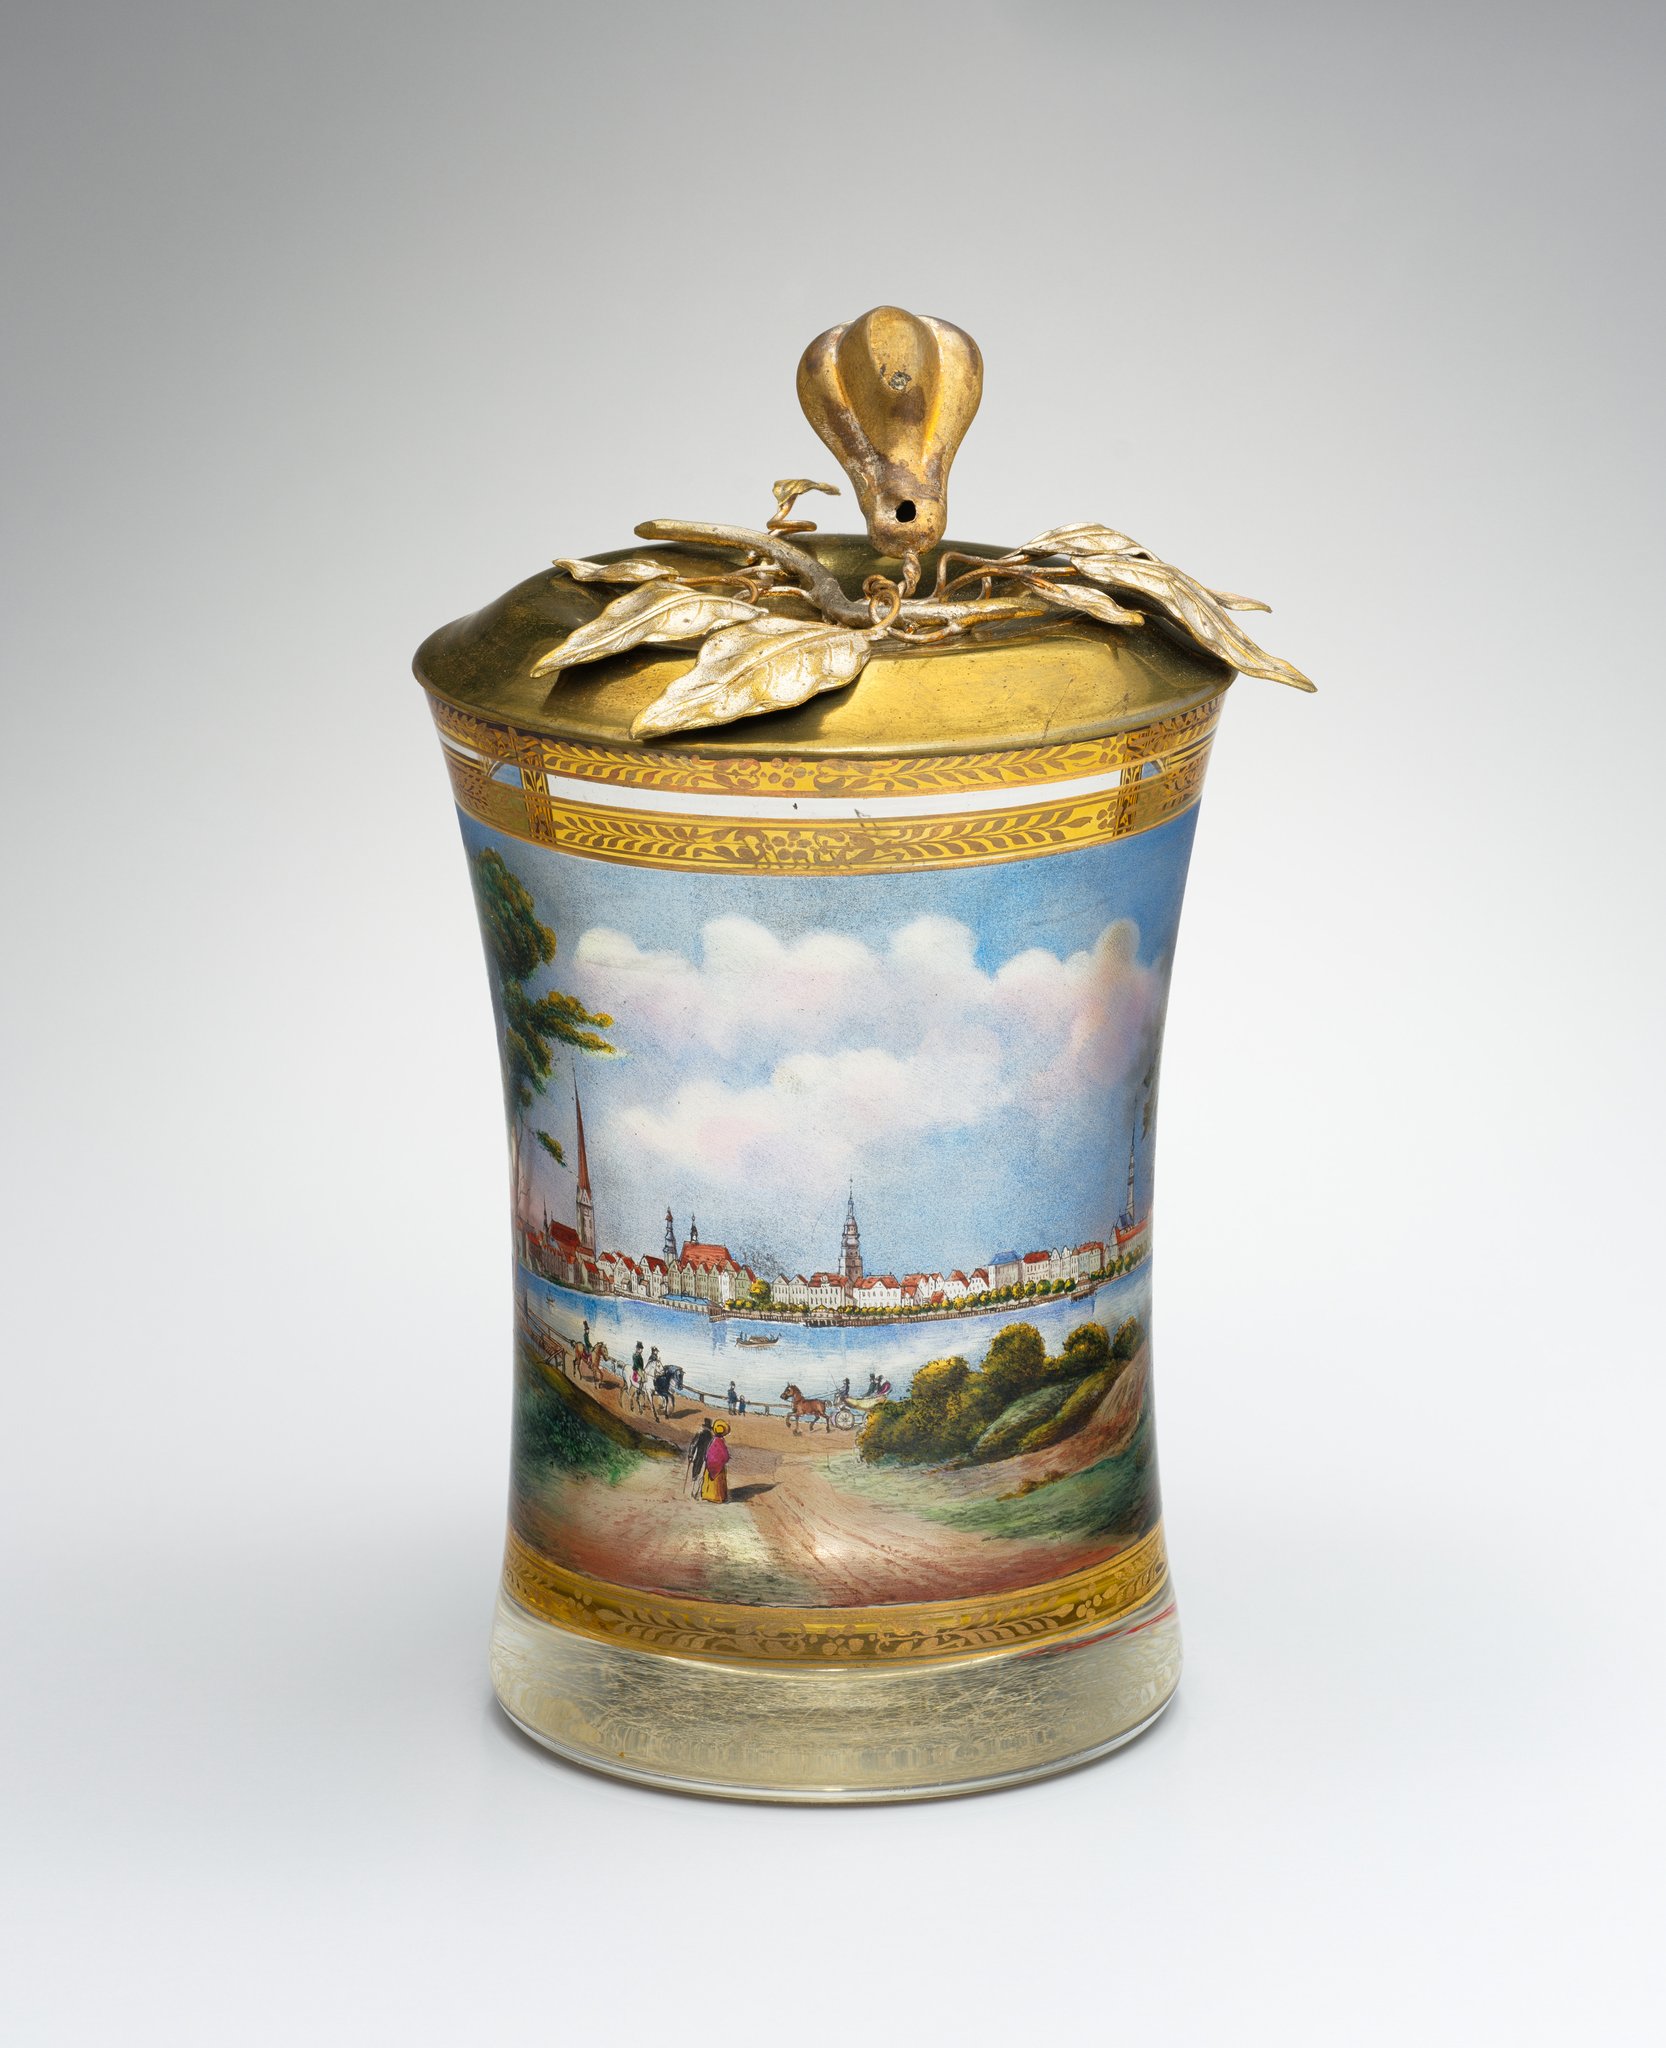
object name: beaker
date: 1820-1830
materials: glass, metal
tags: cities